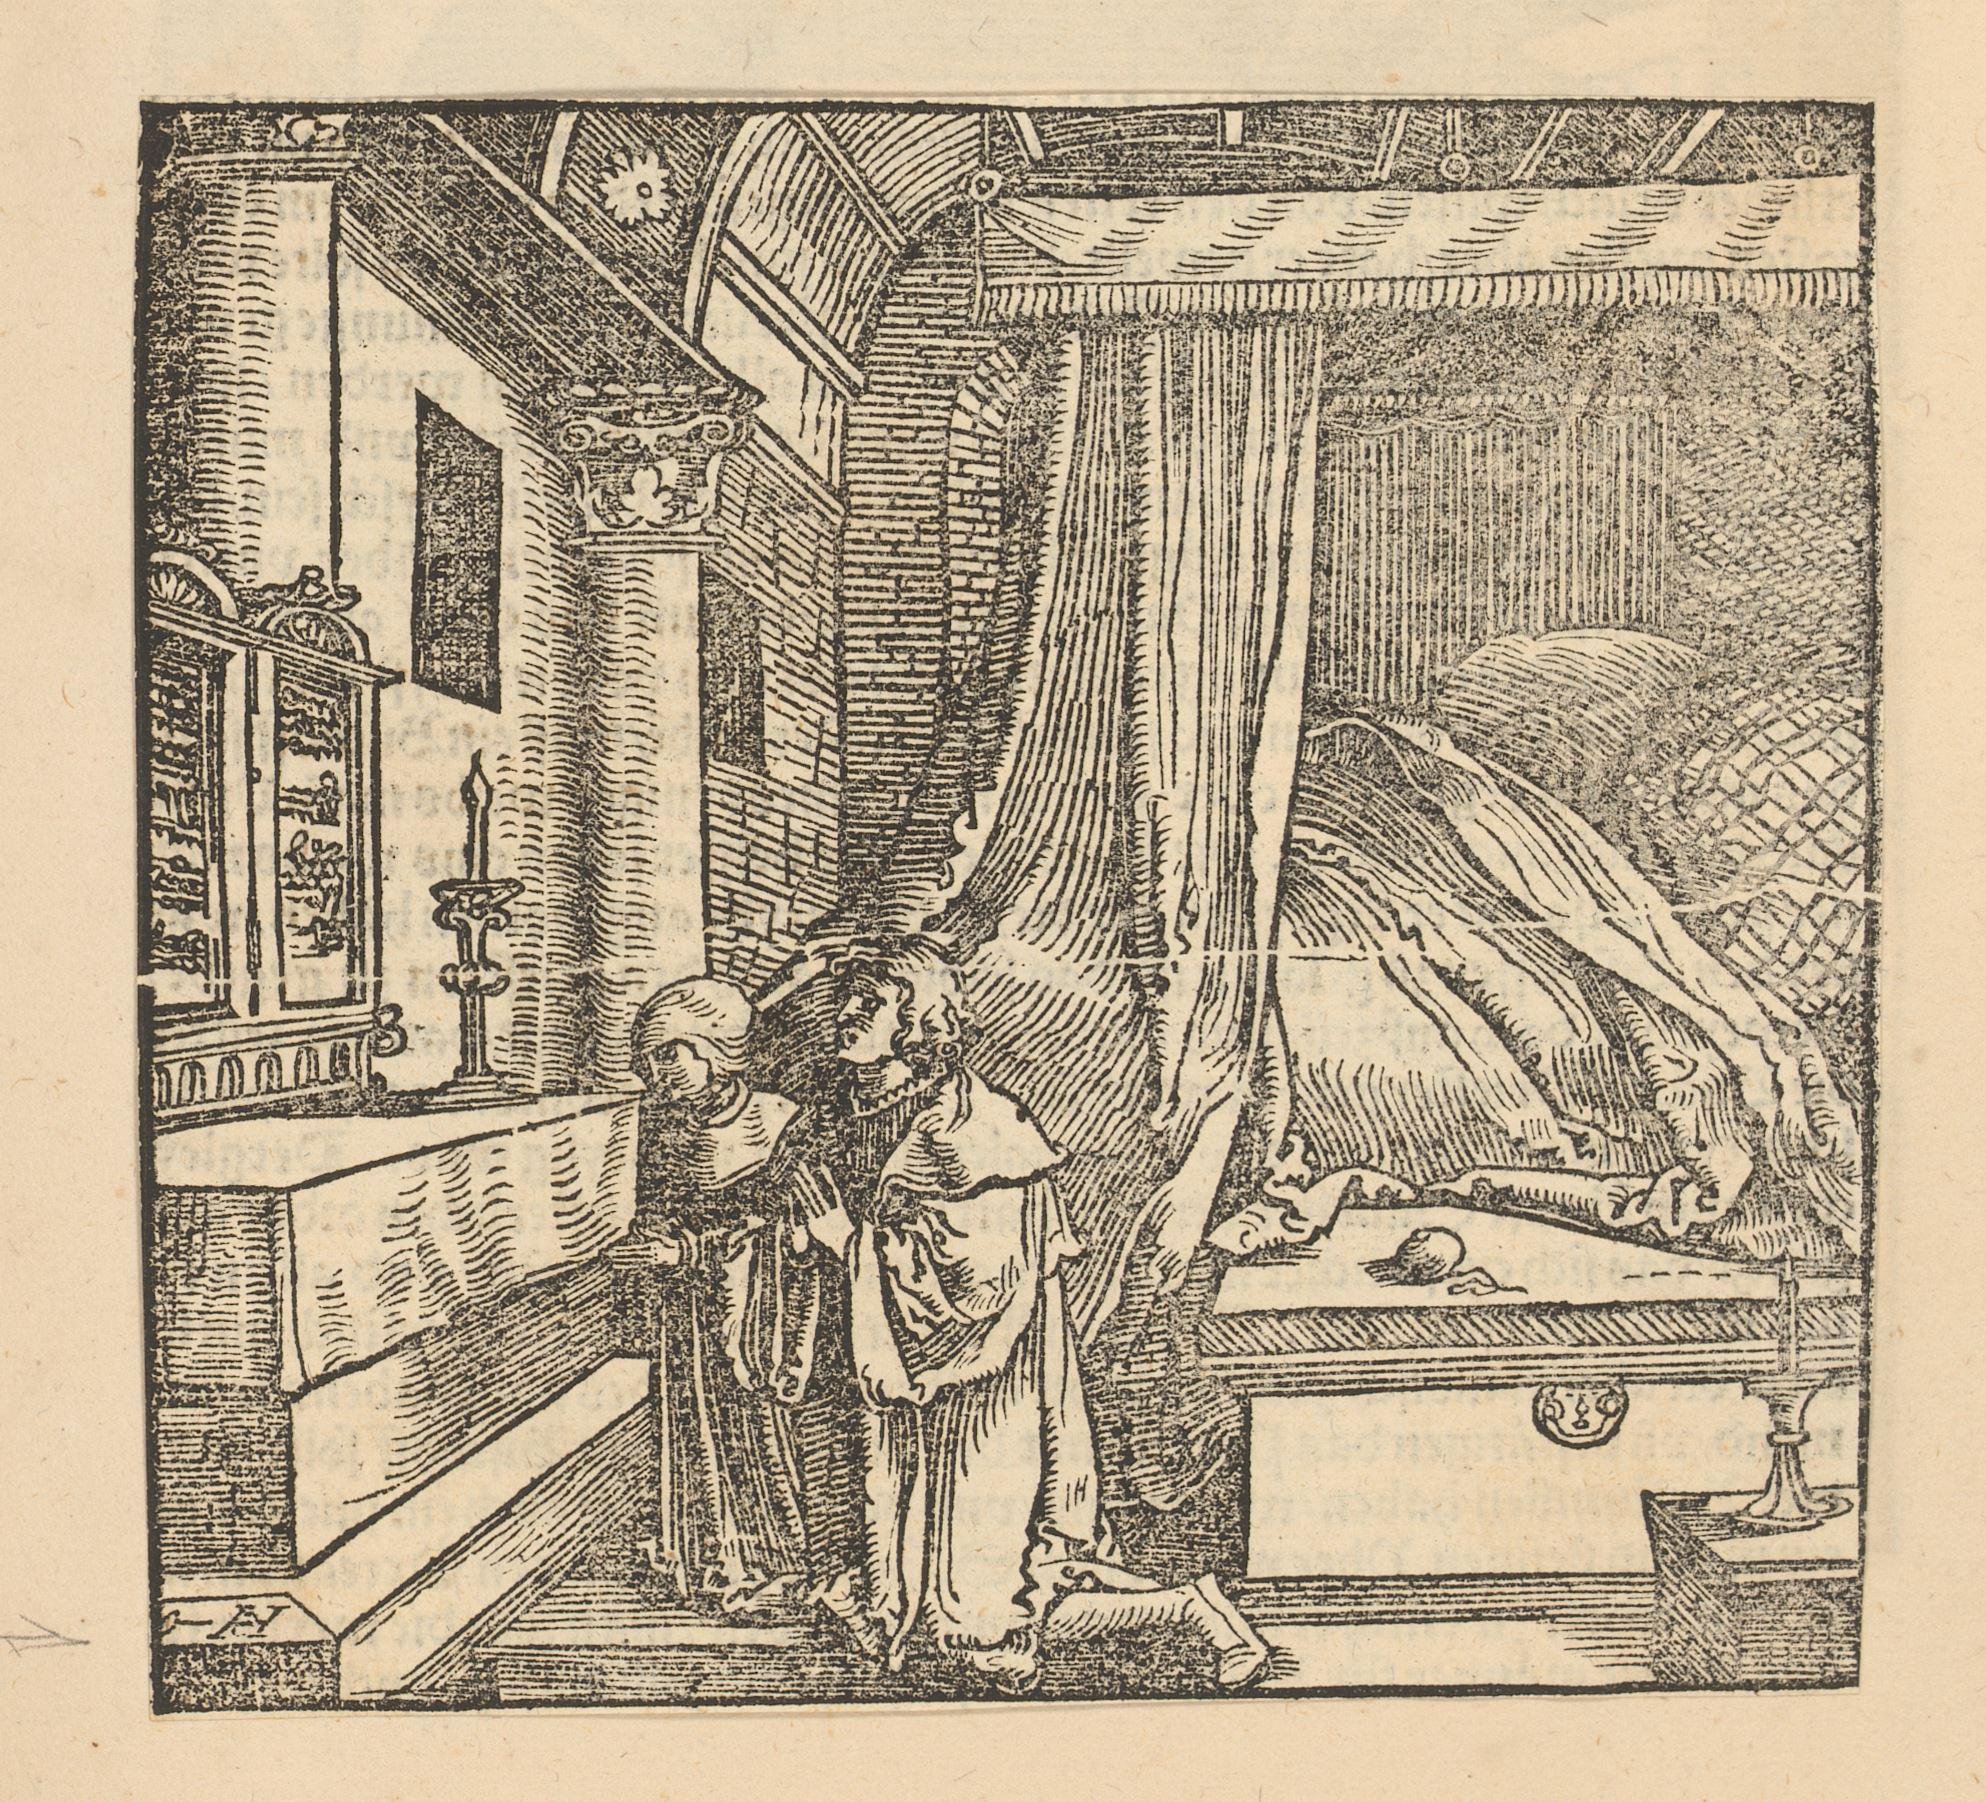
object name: album leaf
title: Twee biddende mensen in een slaapkamer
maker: hans schäufelein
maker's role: print maker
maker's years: 1480-1540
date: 1490-1538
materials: paper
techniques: letterpress printing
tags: prayer at going to bed, or at getting up